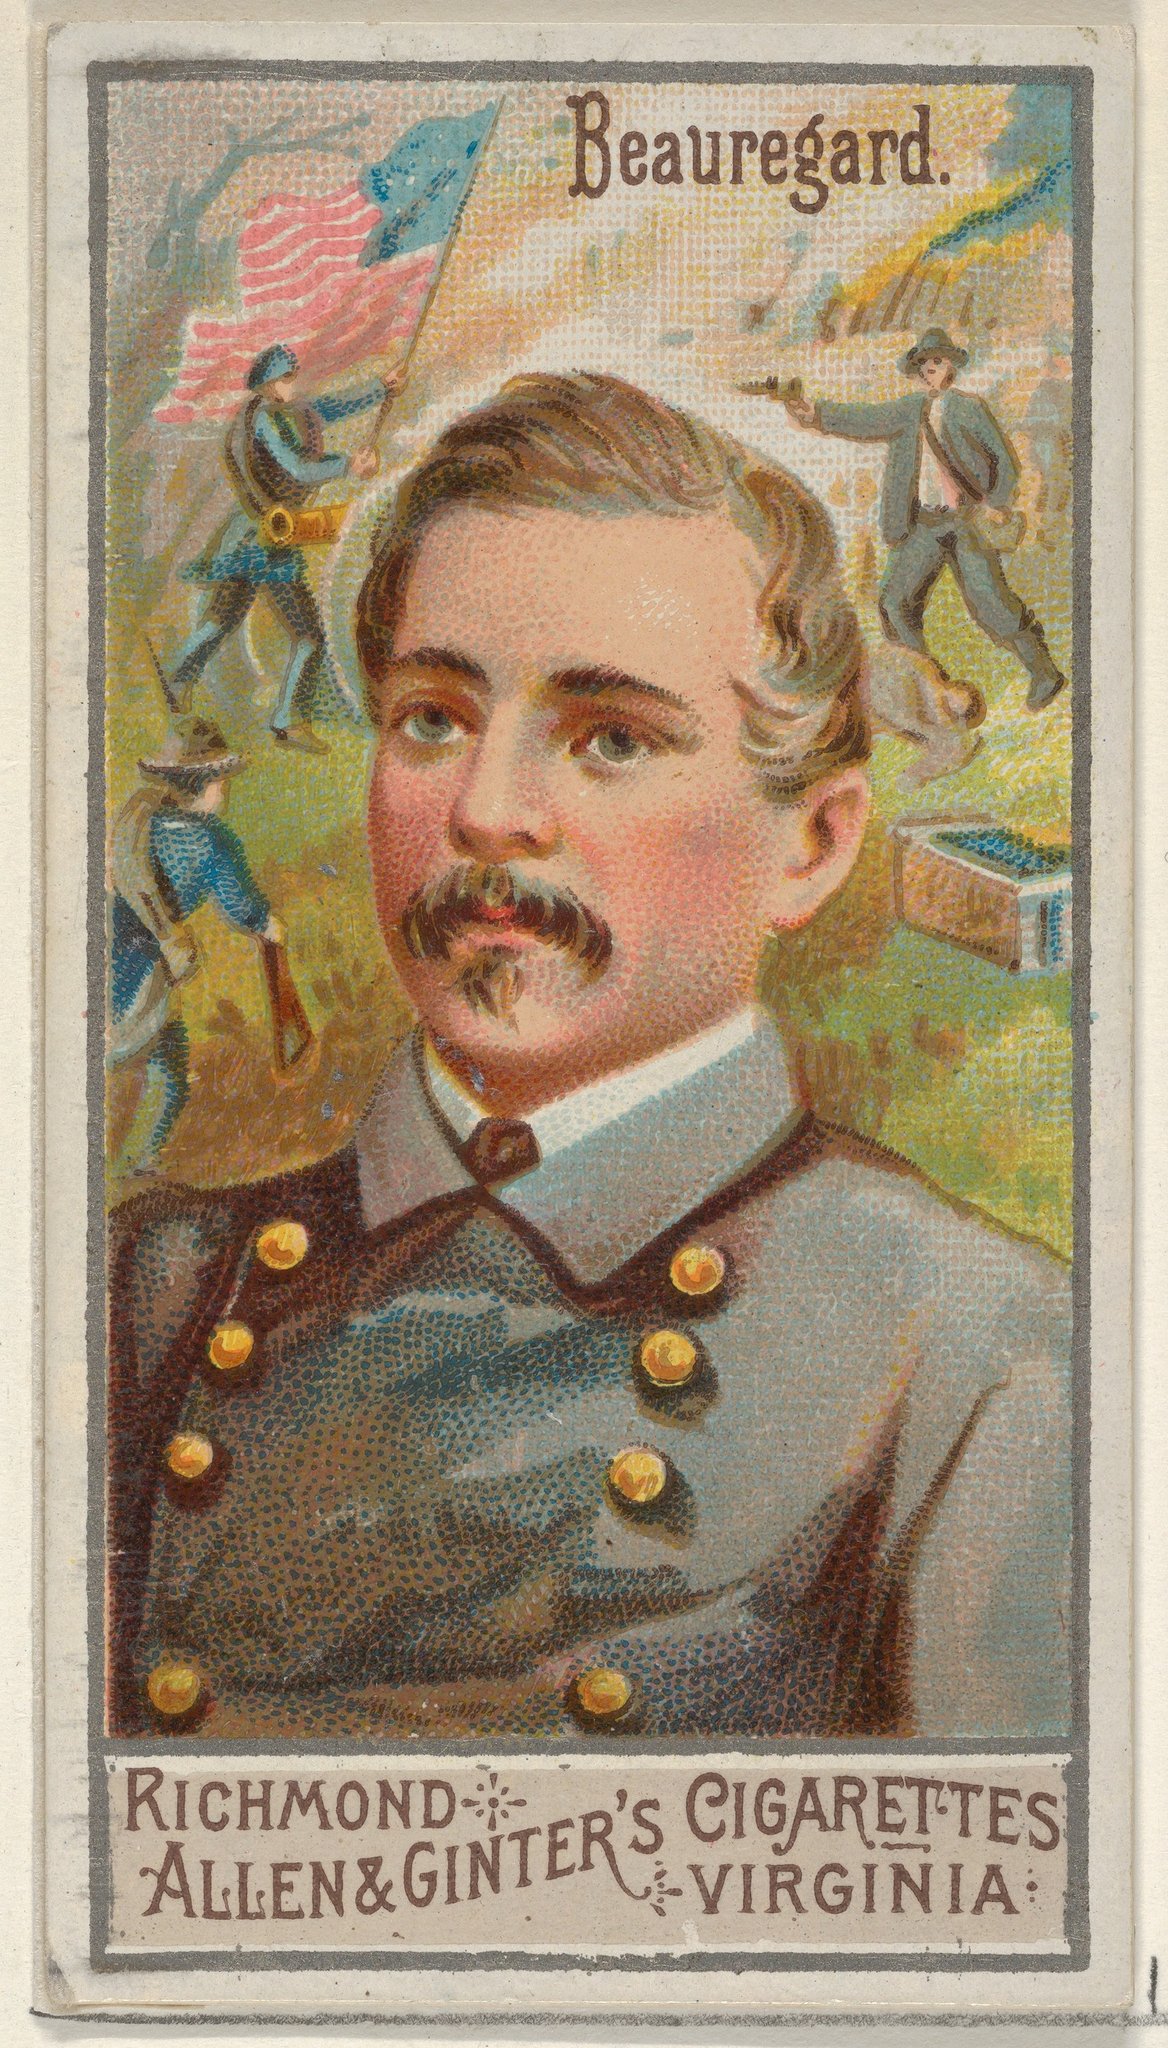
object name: print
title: Pierre Gustave Toutant Beauregard, from the Great Generals series (N15) for Allen & Ginter Cigarettes Brands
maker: allen & ginter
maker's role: publisher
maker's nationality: american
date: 1888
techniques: color lithograph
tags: men,generals